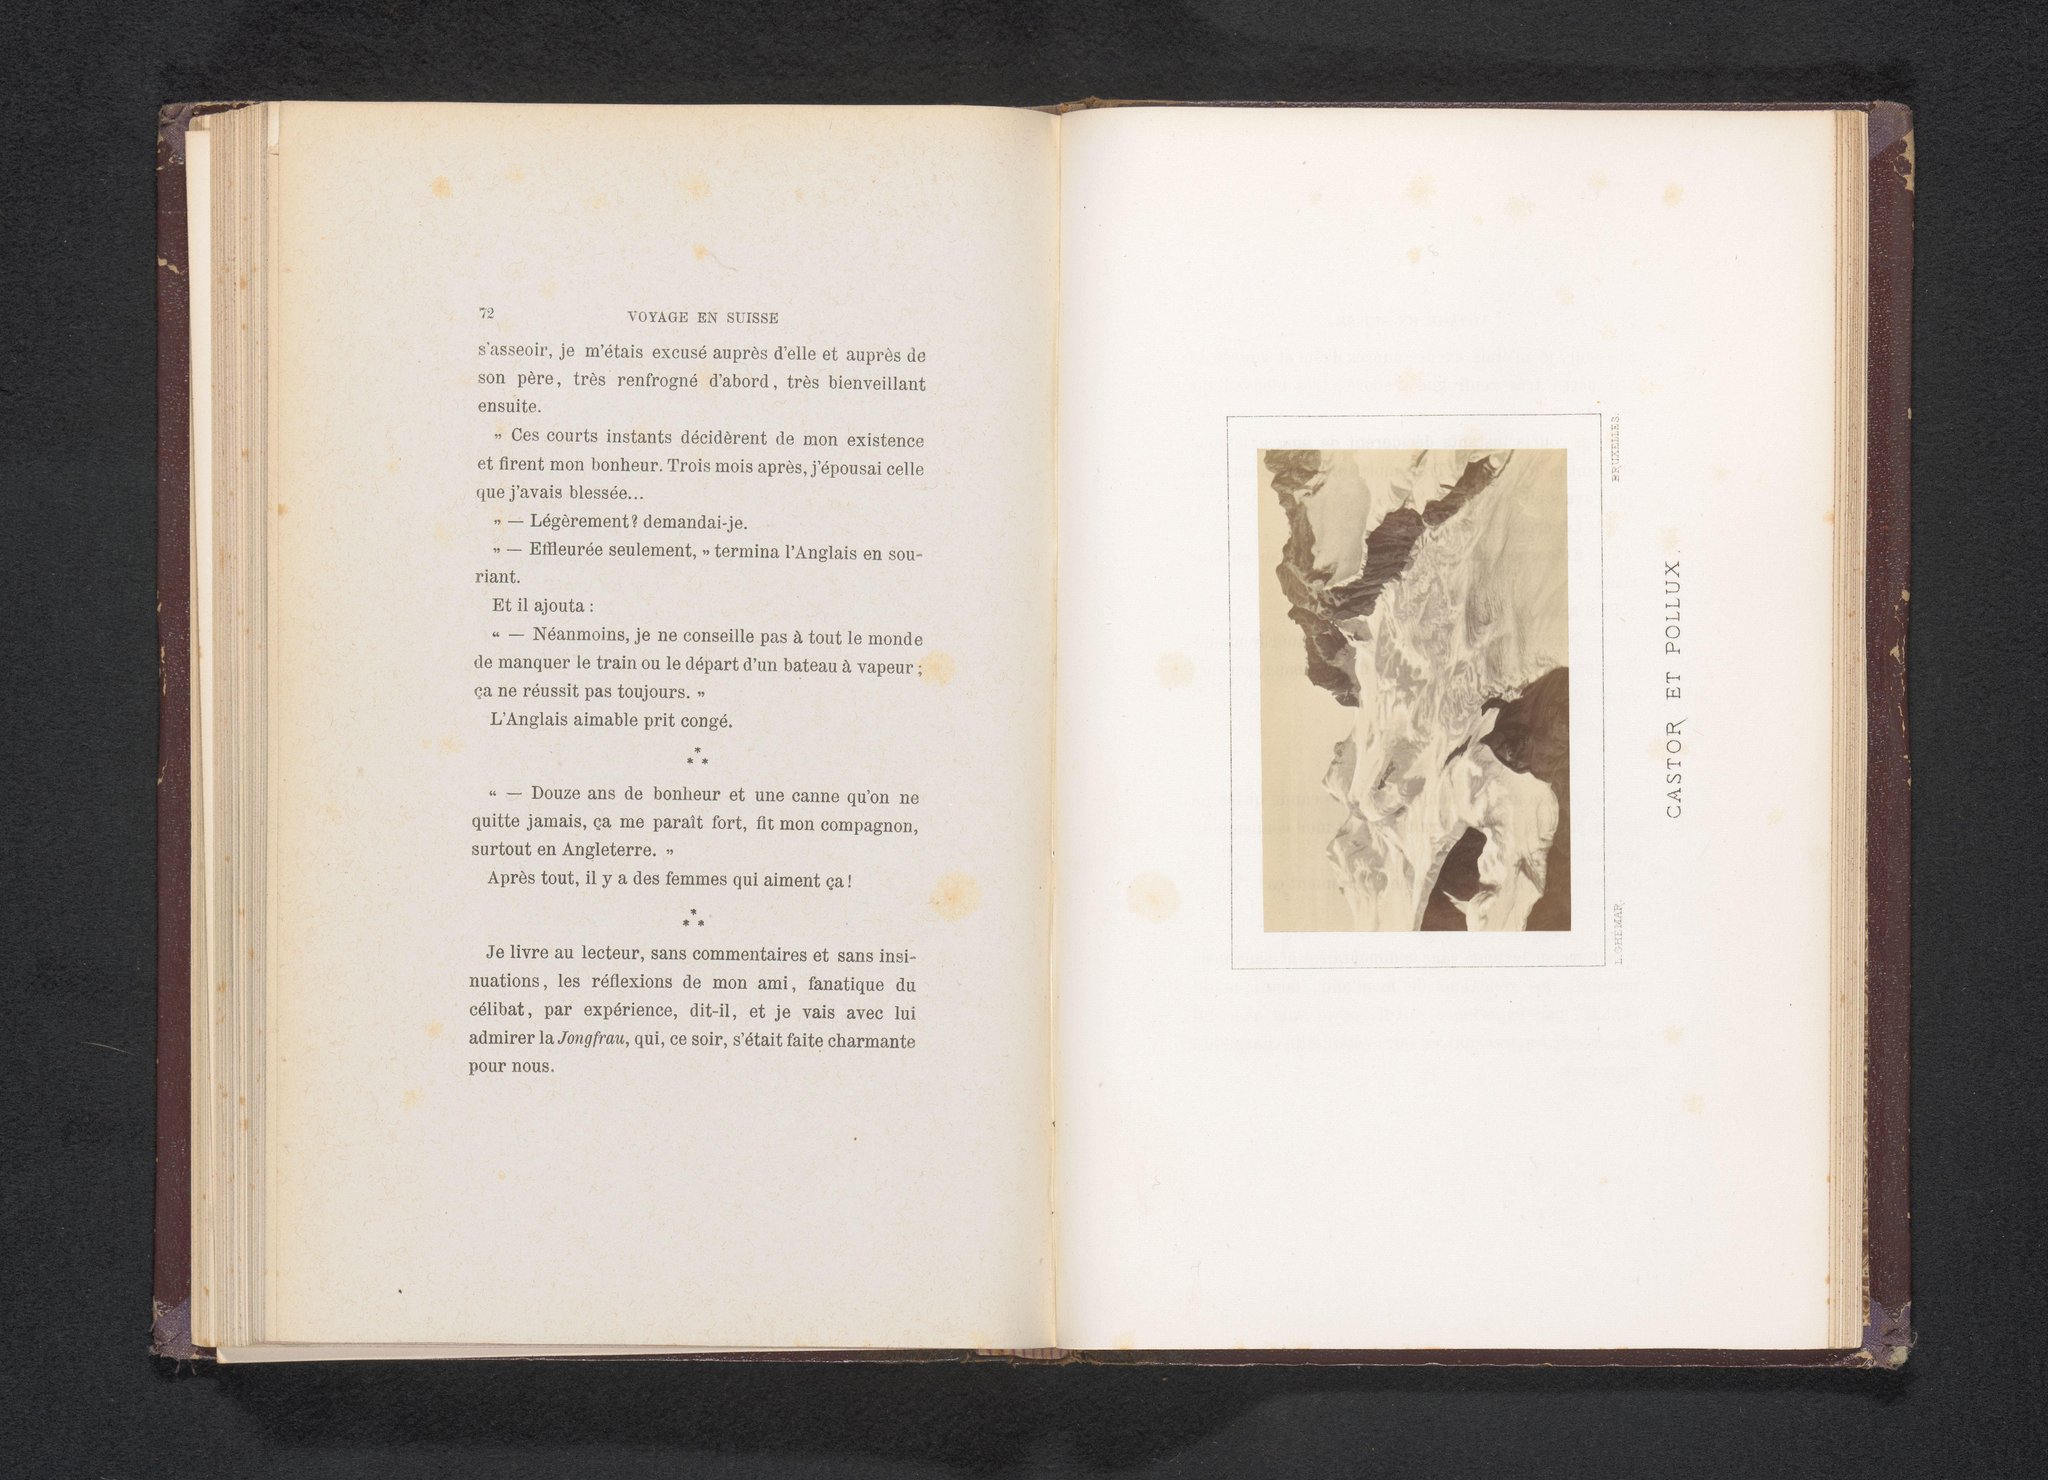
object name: photograph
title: Gezicht op de Castor en de Pollux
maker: louis ghémar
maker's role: draughtsman, print maker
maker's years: 1819-1873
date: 1863-1868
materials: photographic support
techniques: albumen print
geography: wallis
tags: mountain-range, snow peaks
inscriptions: inscription: ‘Bruxelles’